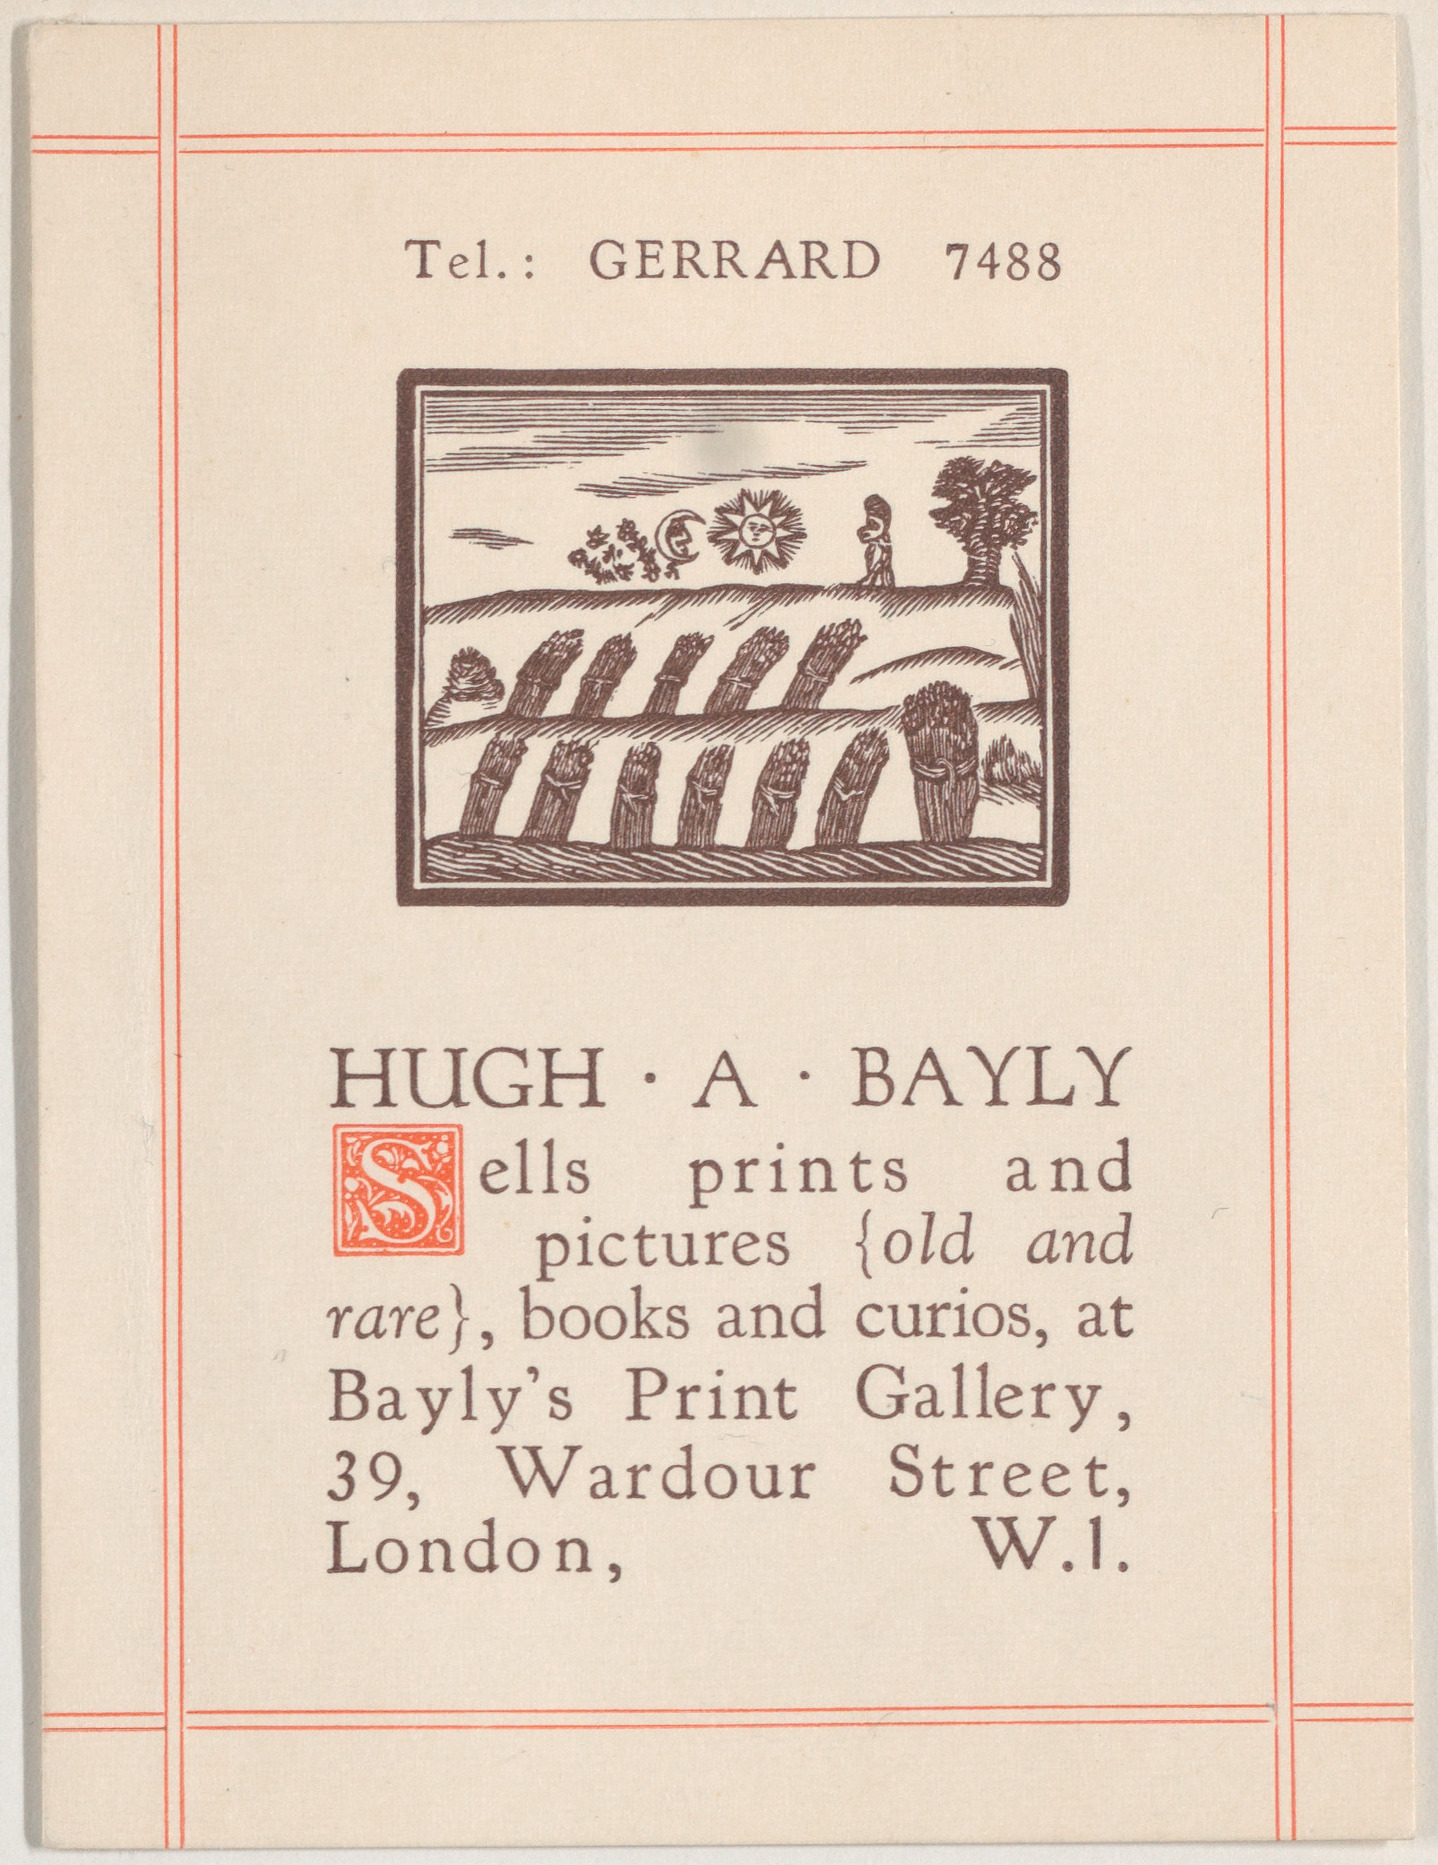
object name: print, trade card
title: Trade card for Hugh A. Bayly, printseller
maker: anonymous, british, 19th century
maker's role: artist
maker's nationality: british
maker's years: 1800-1900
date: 1801-1900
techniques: lithograph